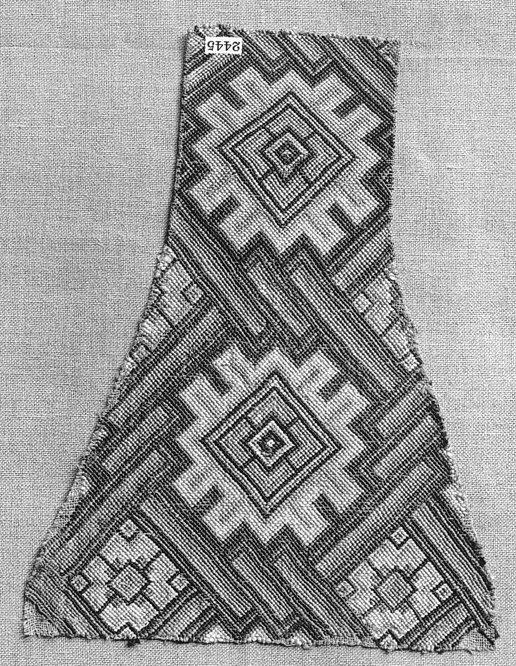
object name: piece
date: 1801-1900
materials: linen, silk